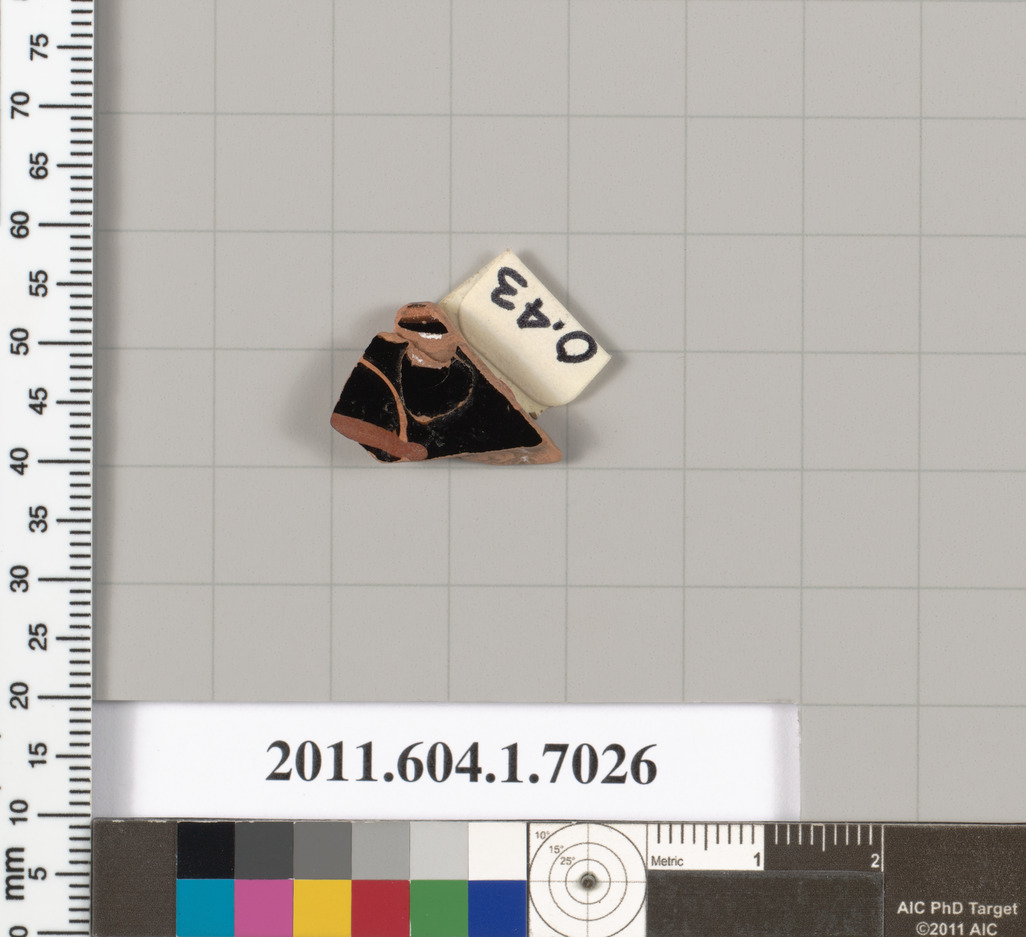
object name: kylix fragment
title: Terracotta rim fragment of a kylix (drinking cup)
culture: greek, attic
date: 500-480 BCE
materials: terracotta